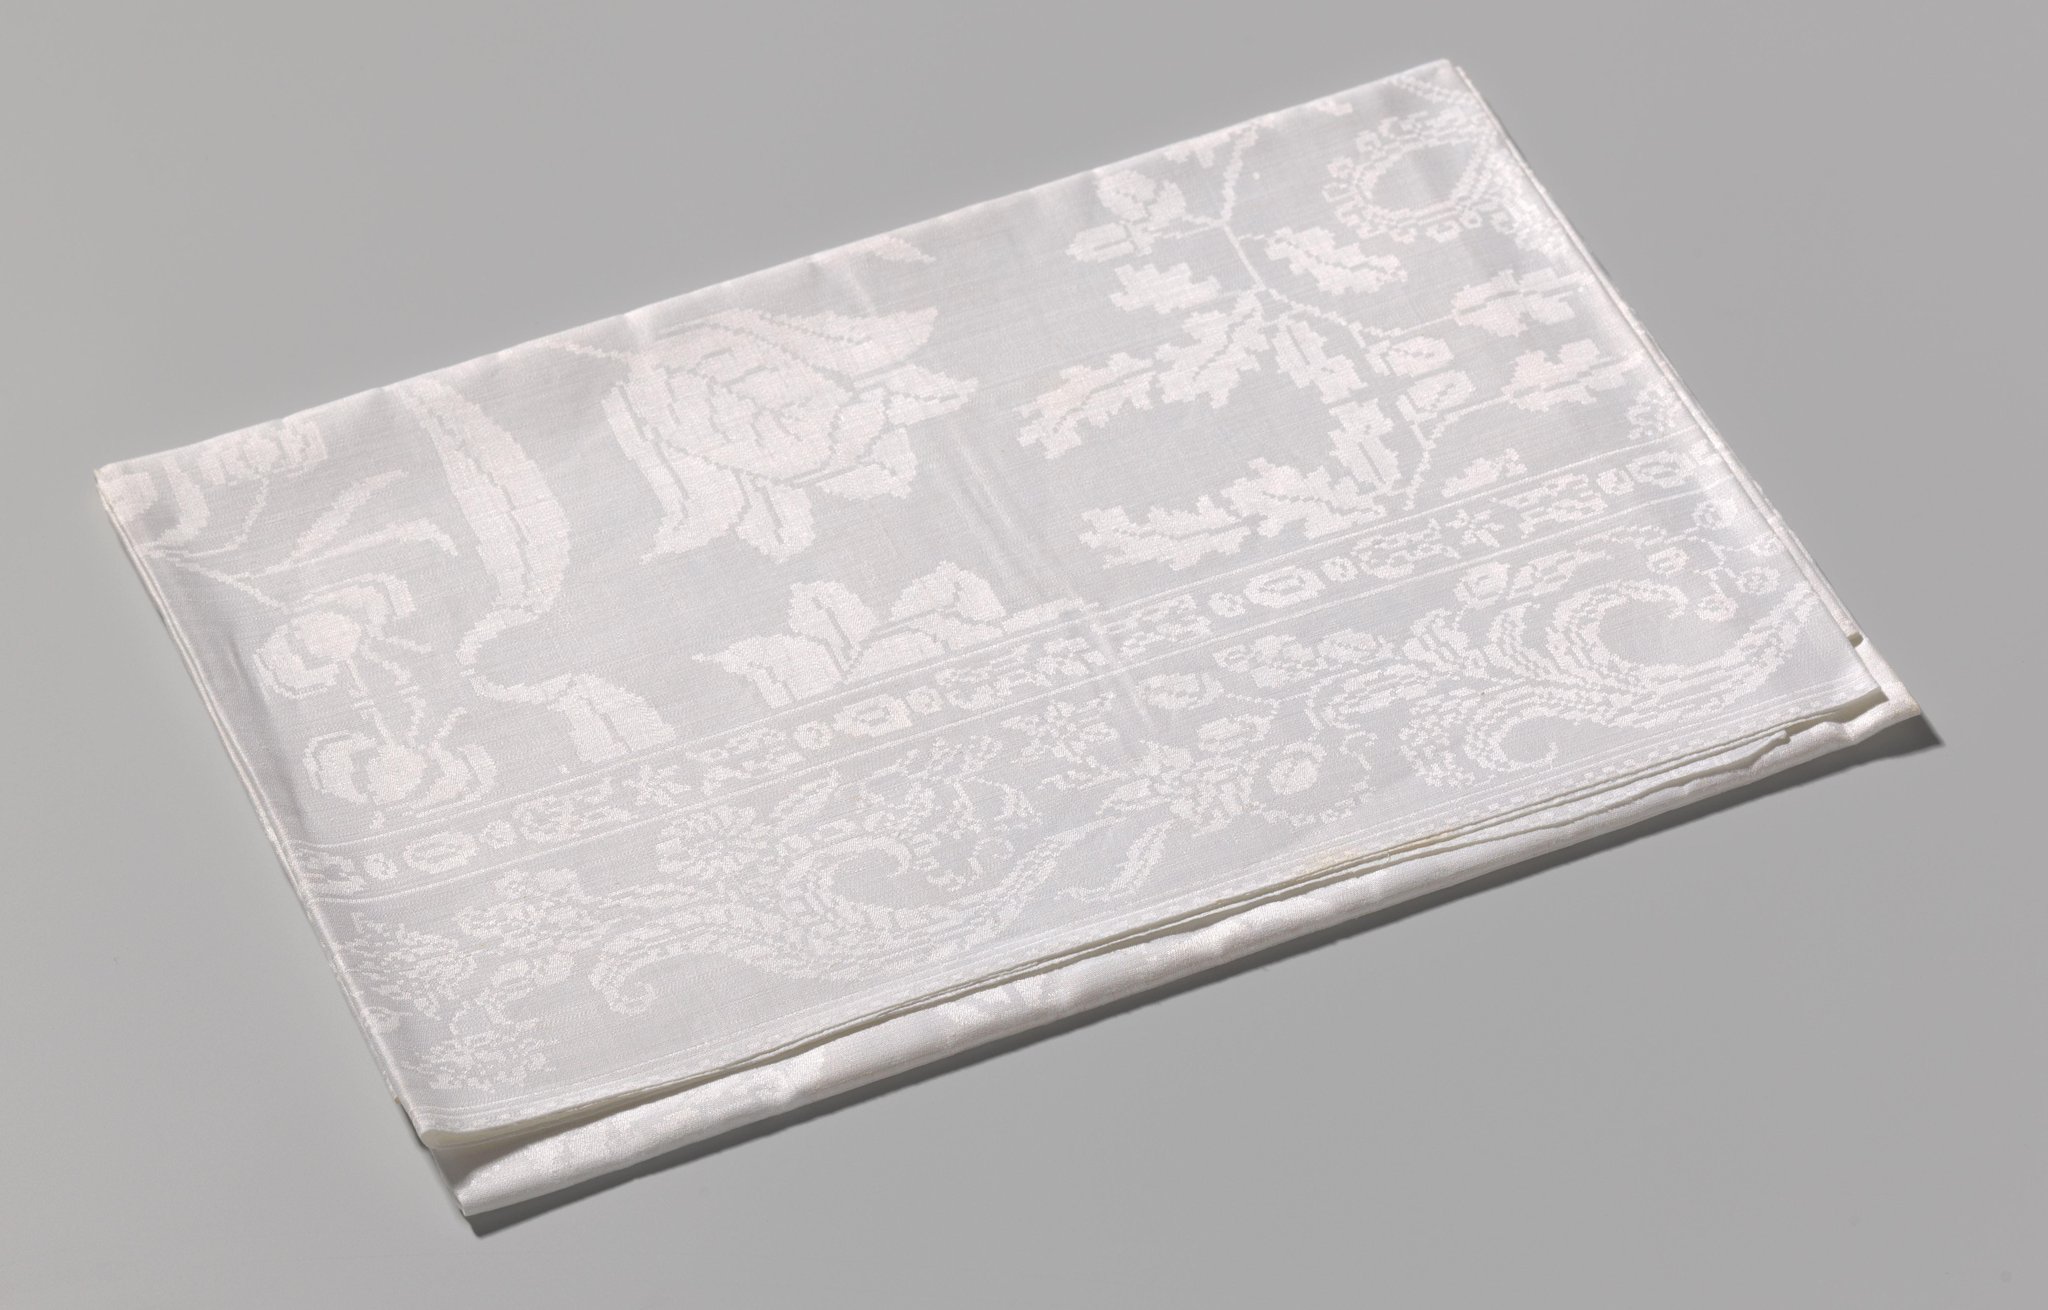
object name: napkin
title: Servet van wit linnendamast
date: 1680-1690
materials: linen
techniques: damask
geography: northern netherlands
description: Wit linnendamasten servet met een patroon van bloemenkransen en ruikers.